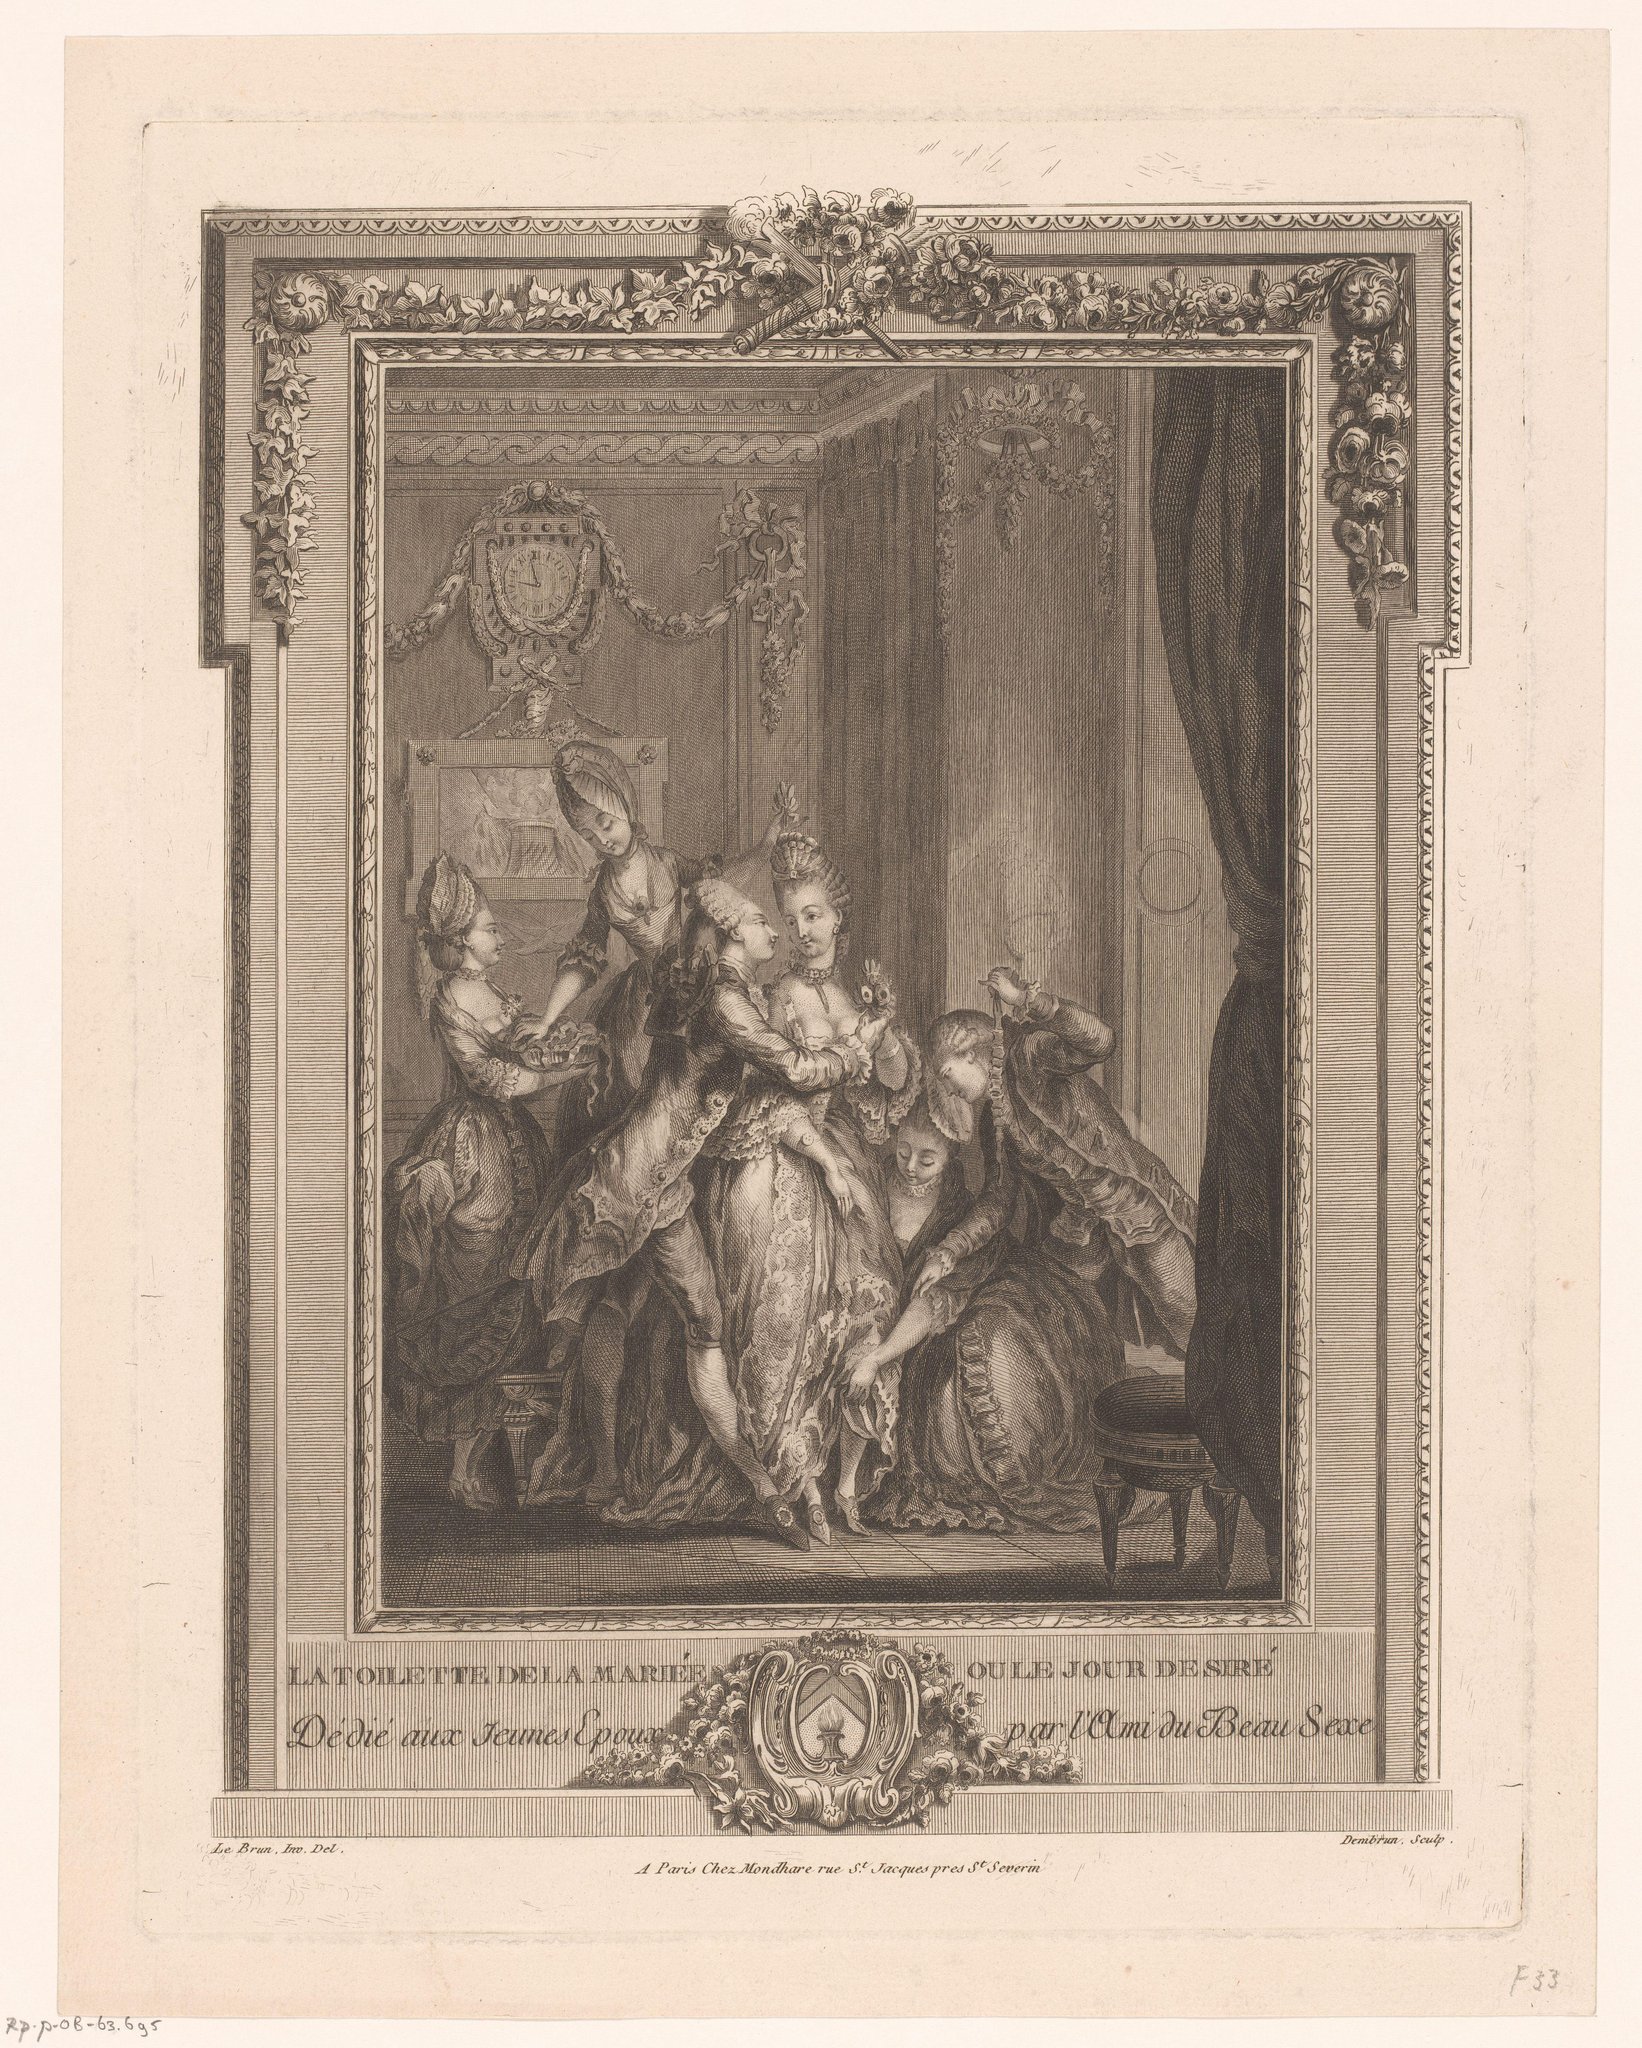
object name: print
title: Ochtendtoilet van de pas getrouwde vrouw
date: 1751-1808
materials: paper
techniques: engraving, etching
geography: france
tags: making toilet, dress, gown: morning dress (+ women's clothes), marriage, married couple, 'matrimonium', putting on or taking off stockings, dressing someone else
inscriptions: address: ‘A Paris Chez Mondhare, rue St. Jacques pres St. Séverin’, signature: ‘Dambrun sc.’, caption: ‘Dedié aux Jeunes Epoux par l'Ami de Beau Sexe’, collector's mark: Lugt 2228, title: ‘LA TOILETTE DE LA MARIÉE OU LE JOUR DE SIRÉ’, signature: ‘Le Brun Inv. Del.’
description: In een vertrek wordt een jonge vrouw door een paar bedienden aangekleed, terwijl haar echtgenoot haar omhelst en een bloem aanbiedt. Twee bedienden zijn bezig met haar kapsel, terwijl twee anderen haar kousenband willen bevestigen. Scène gevat in omlijsting met bloemguirlande.